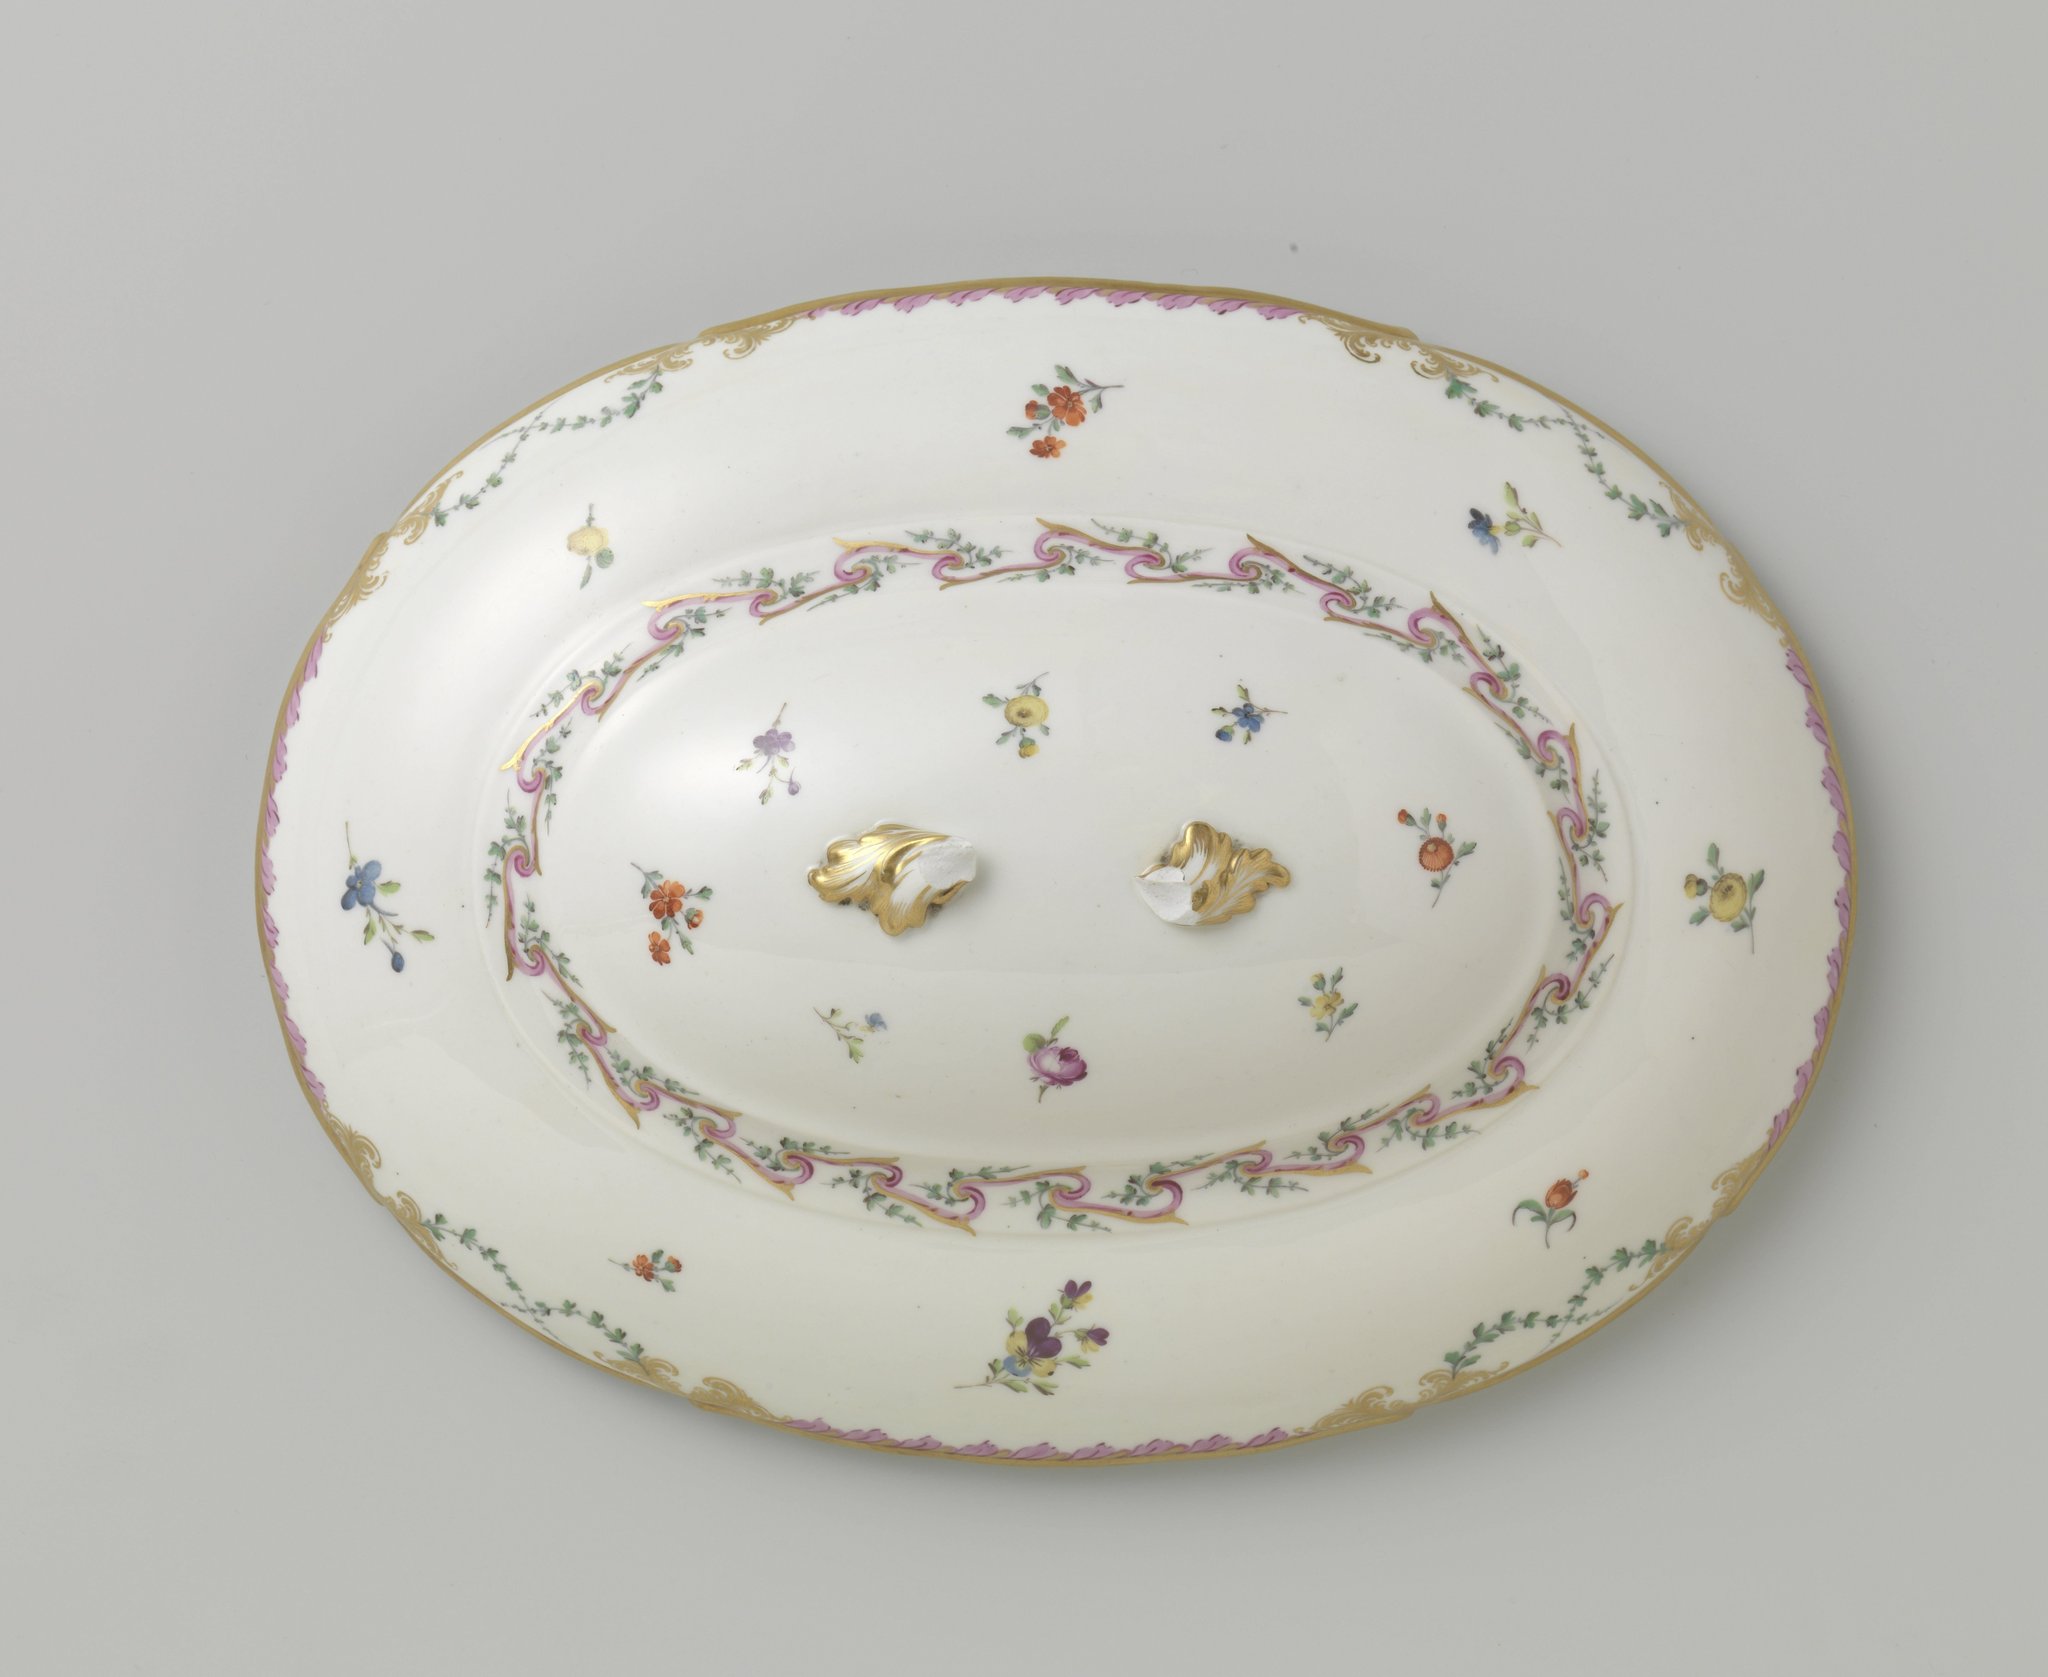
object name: vessel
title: Deksel met knop, ovaal van vorm, behorend bij een servies met geslingerd lintmotief met bladertakken, bloemboeketten en gestrooide bloemtakken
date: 1780-1820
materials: porcelain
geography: loosdrecht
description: Deksel met knop, ovaal van vorm, behorend bij een servies van porselein met geslingerd motief in paars en goud met groene bladertakken, bloemboeketten en gestrooide bloemtakken. Randen lichtgegolfd met decoratie in goud met paars bladmotief waartussen groen gekruist bladmotief. Gemerkt: M.O.L. en AMSTEL.